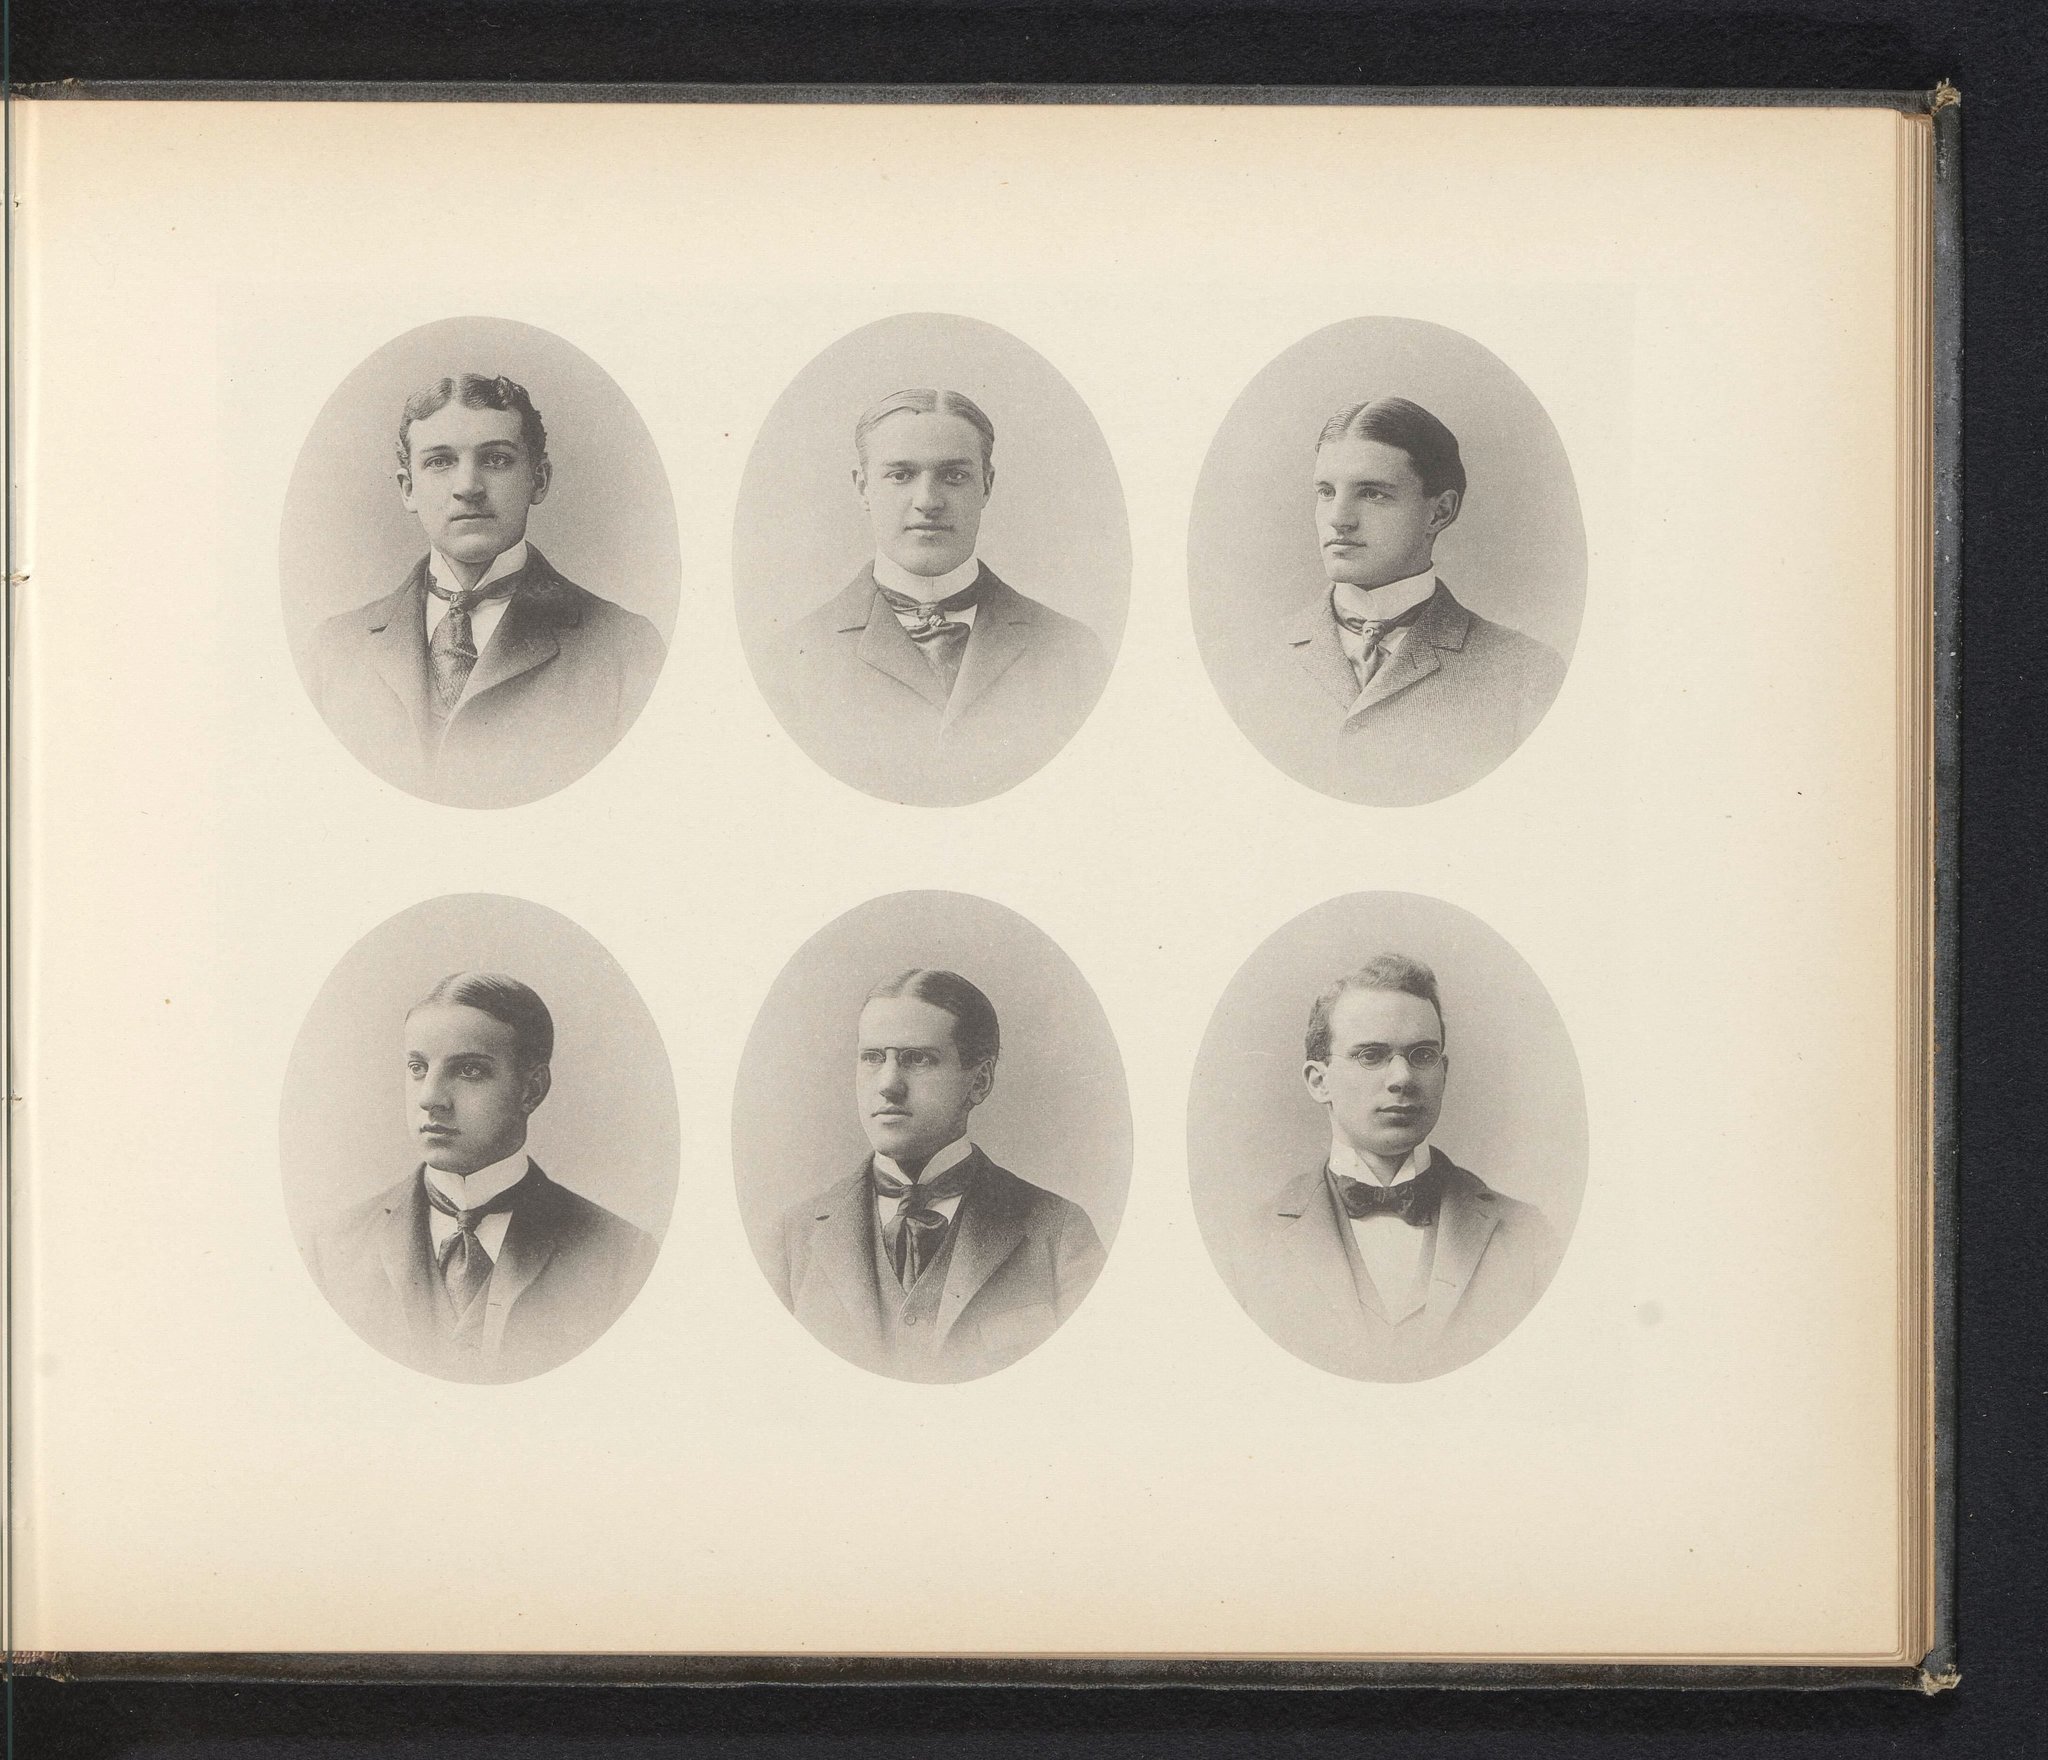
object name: photomechanical print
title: Zes portretten van afgestudeerde studenten van Yale University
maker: Anonymous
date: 1895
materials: paper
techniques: photograph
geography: new york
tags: student